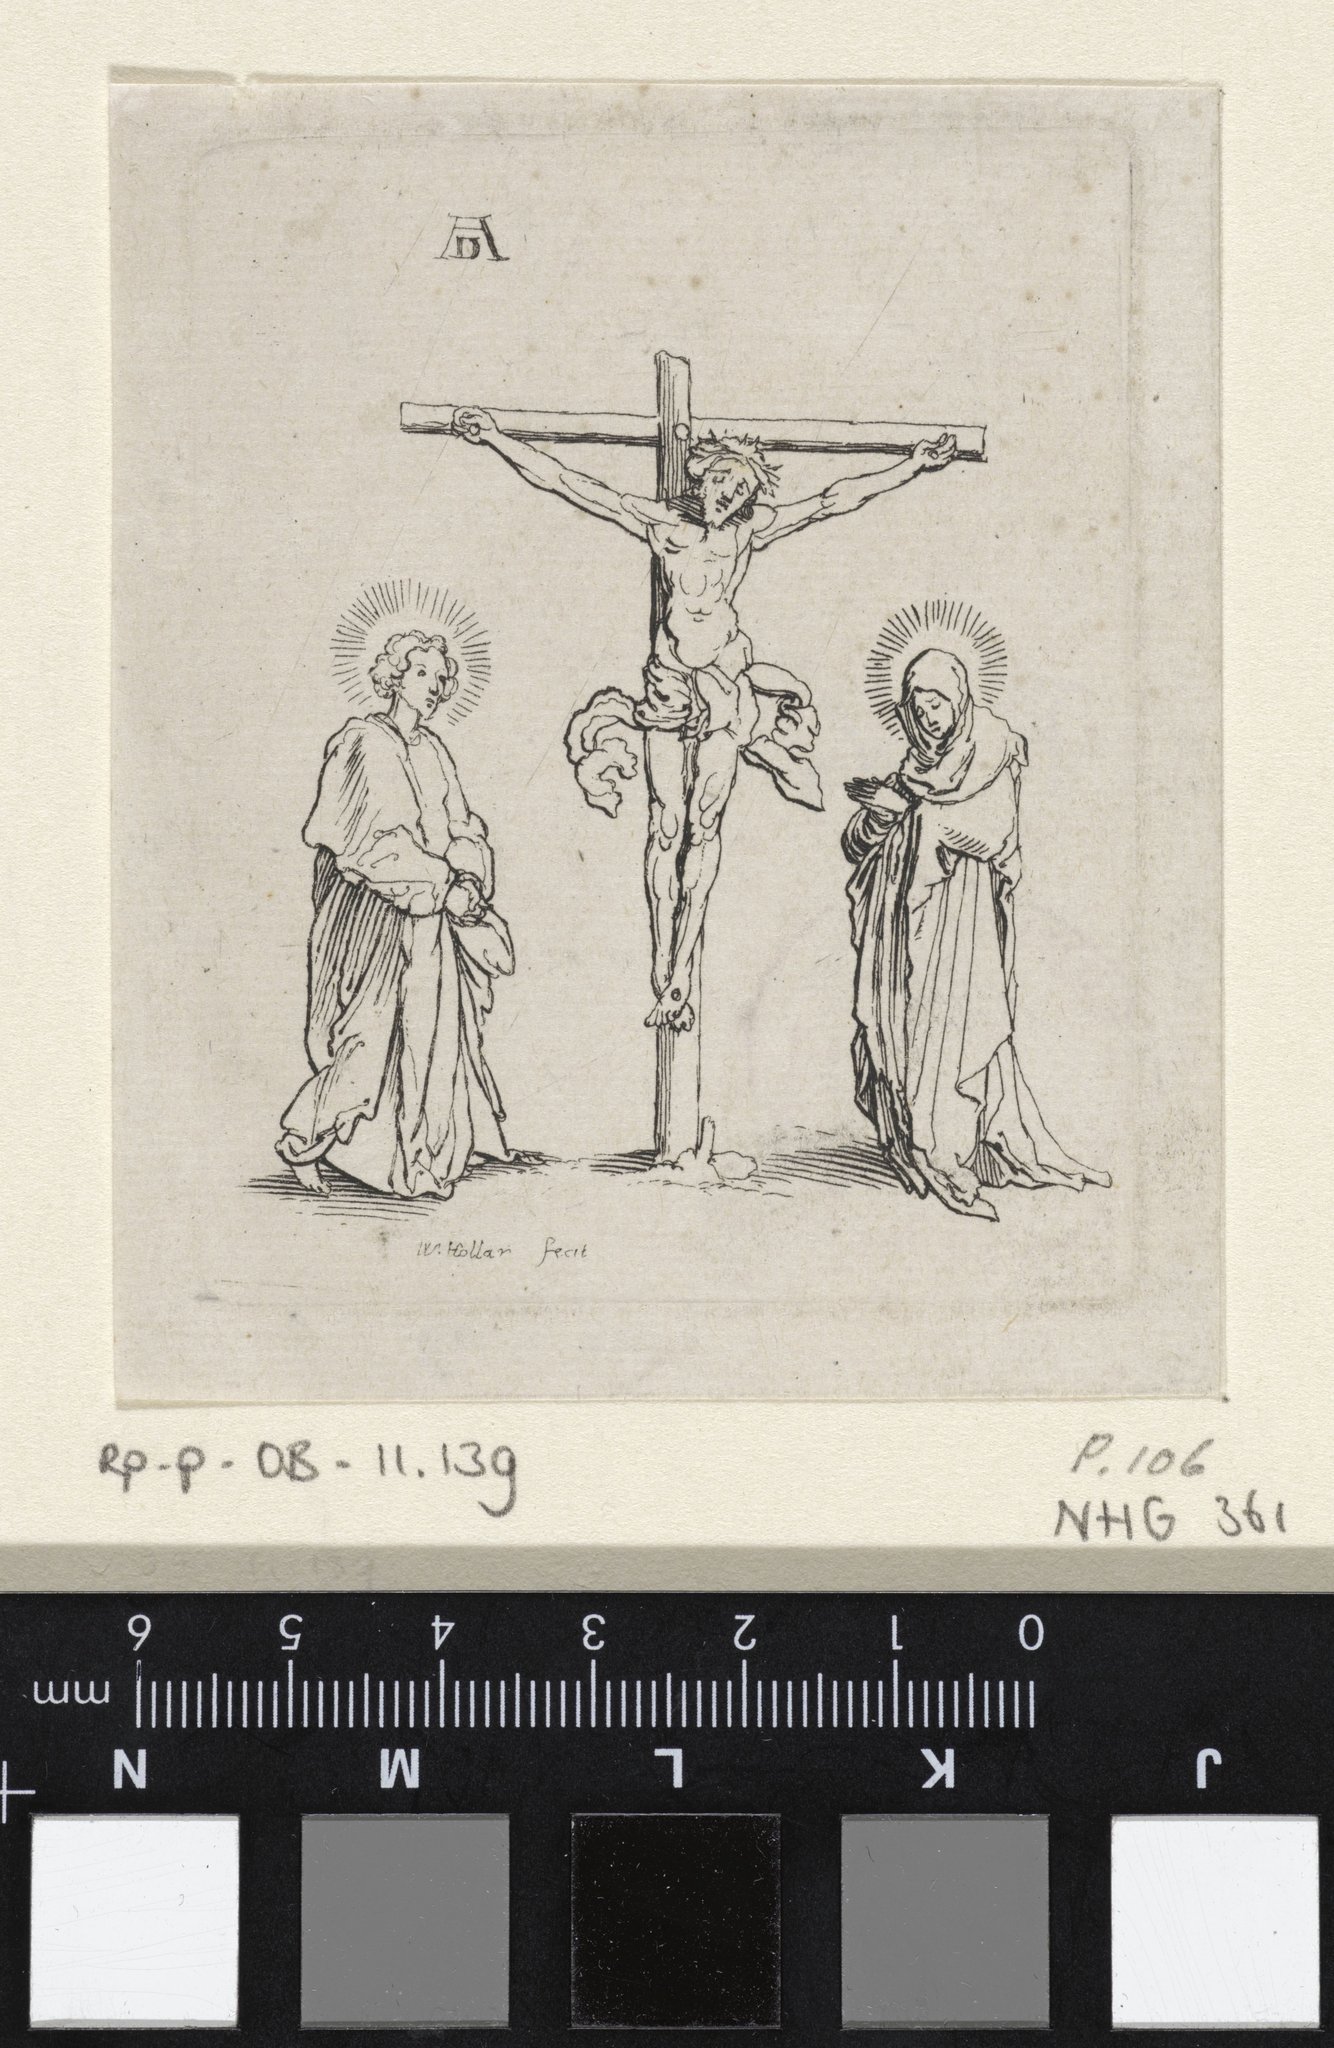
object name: print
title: Religieuze voorstellingen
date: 1642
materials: paper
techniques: etching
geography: london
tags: crucified christ with mary and john on either side of the cross; holy rood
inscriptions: collector's mark: Lugt 240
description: De prent maakt deel uit van een vierdelige serie prenten met religieuze voorstellingen.